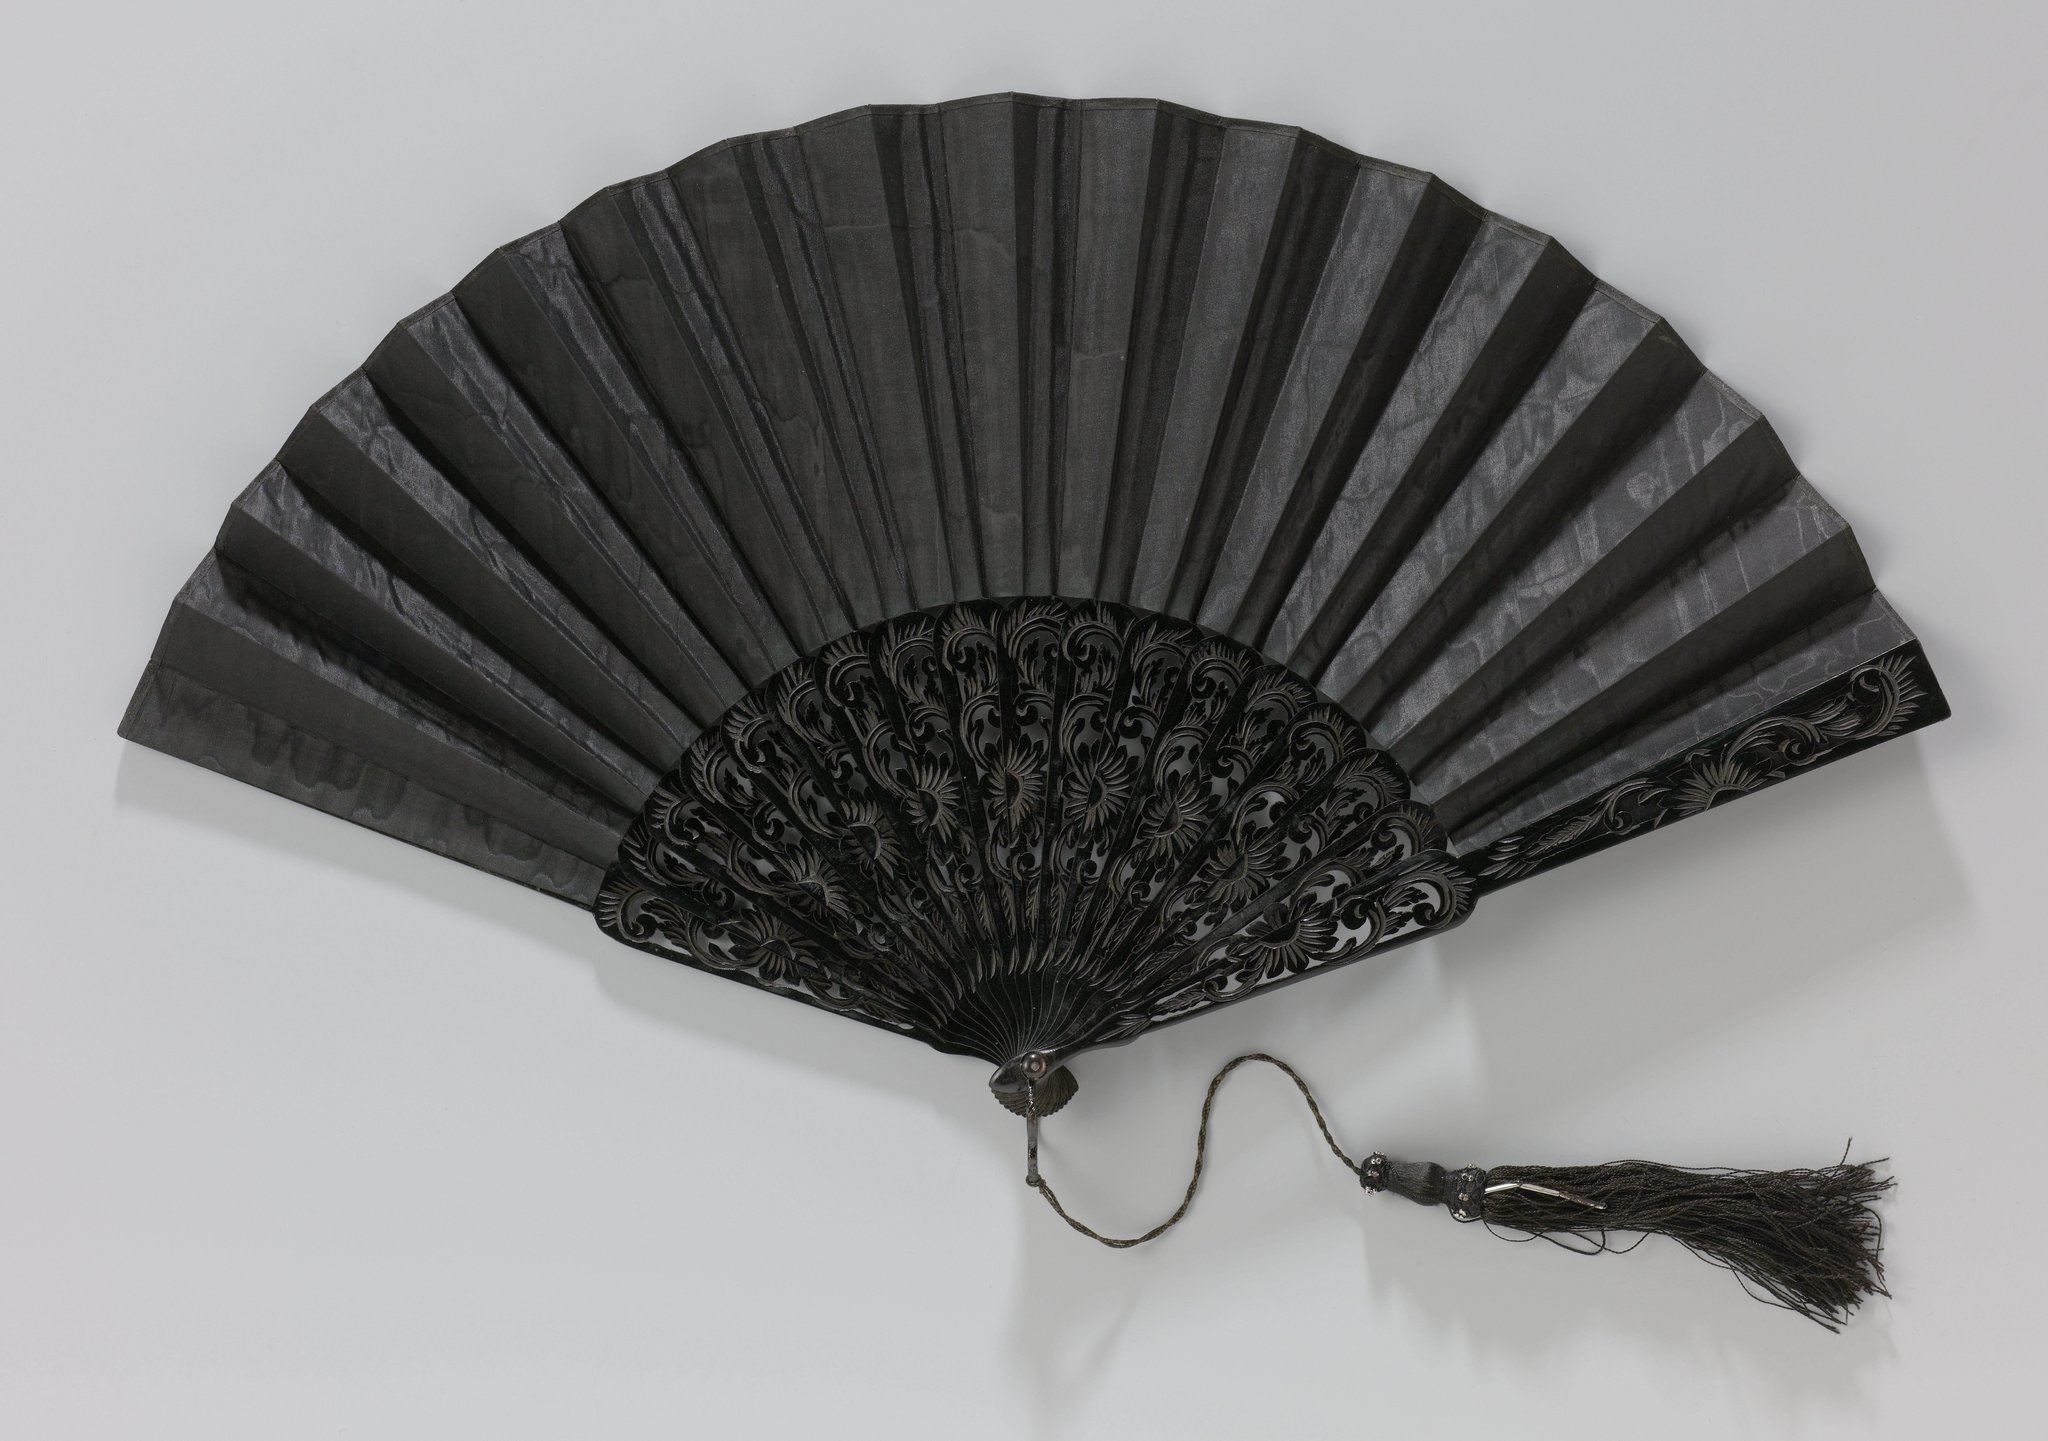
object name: rouwwaaier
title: Vouwwaaier met onversierd blad van zwarte moiré-zijde op ajour en in reliëf gesneden montuur van zwart gelakt hout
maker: Anonymous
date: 1880-1900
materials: lacquer, metal, mother of pearl, silk, steel, wood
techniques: cutting, embroidery, lacquer, weave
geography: netherlands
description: Vouwwaaier met onversierd dubbel blad van zwarte moiré-zijde op ajour en in reliëf gesneden montuur van zwart gelakt hout. Het montuur telt 18 benen met een gesneden bloemmotief. Het schijfje bij de stalen sluitpin is van zwart parelmoer, waaraan een zwarte metalen waaierring en een zwarte kwast.